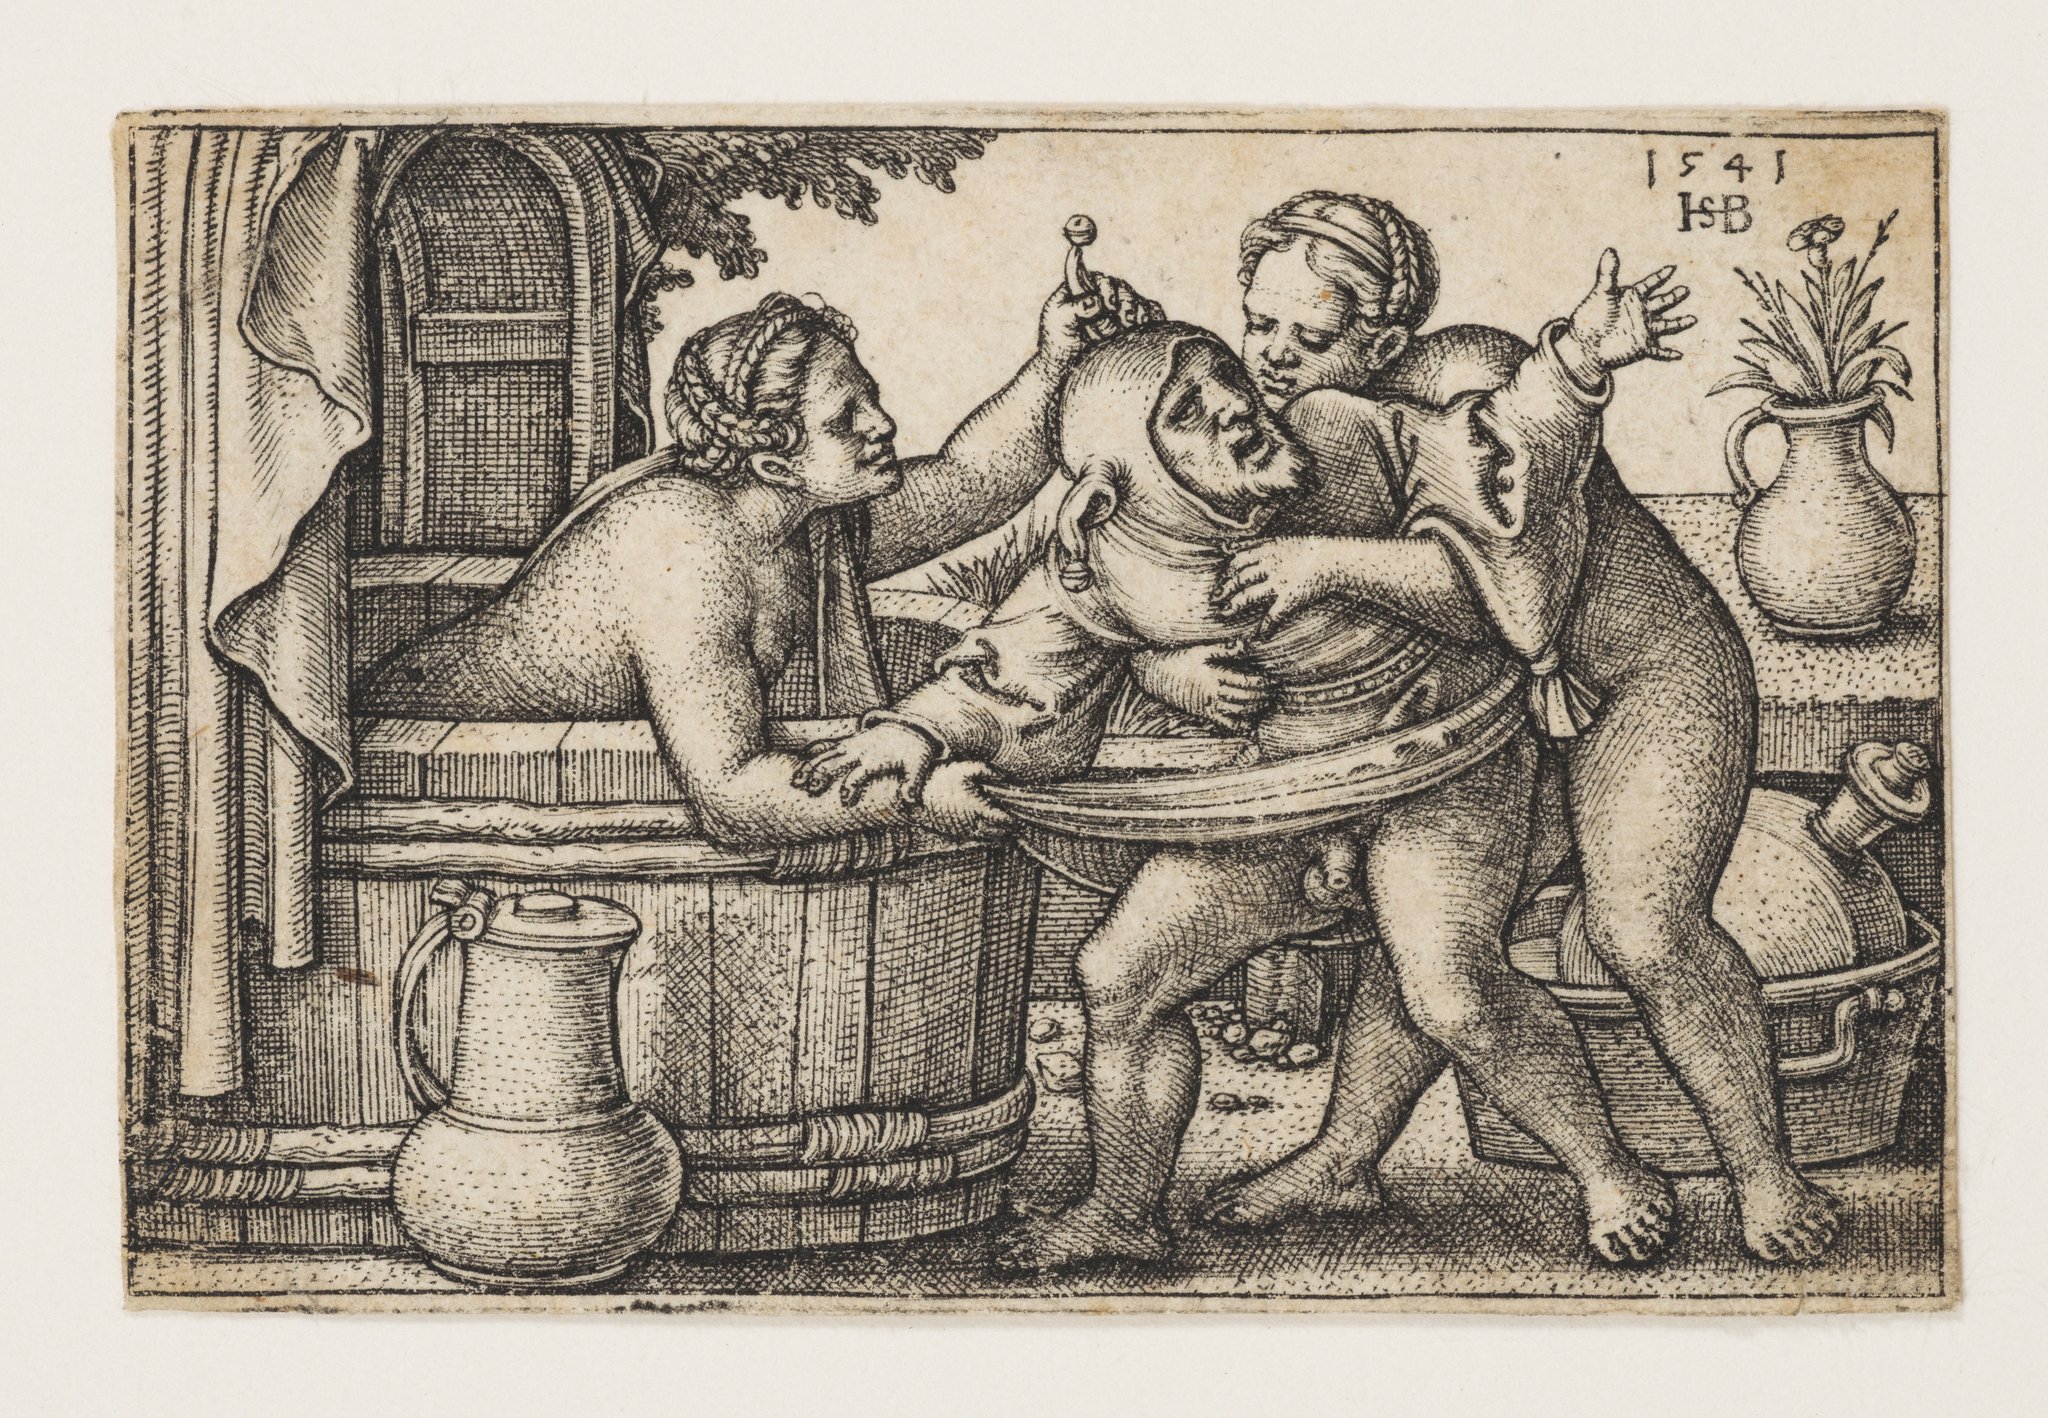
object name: print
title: Buffoon and Two Women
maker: sebald beham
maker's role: artist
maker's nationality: german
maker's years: 1500-1550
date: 1541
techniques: engraving